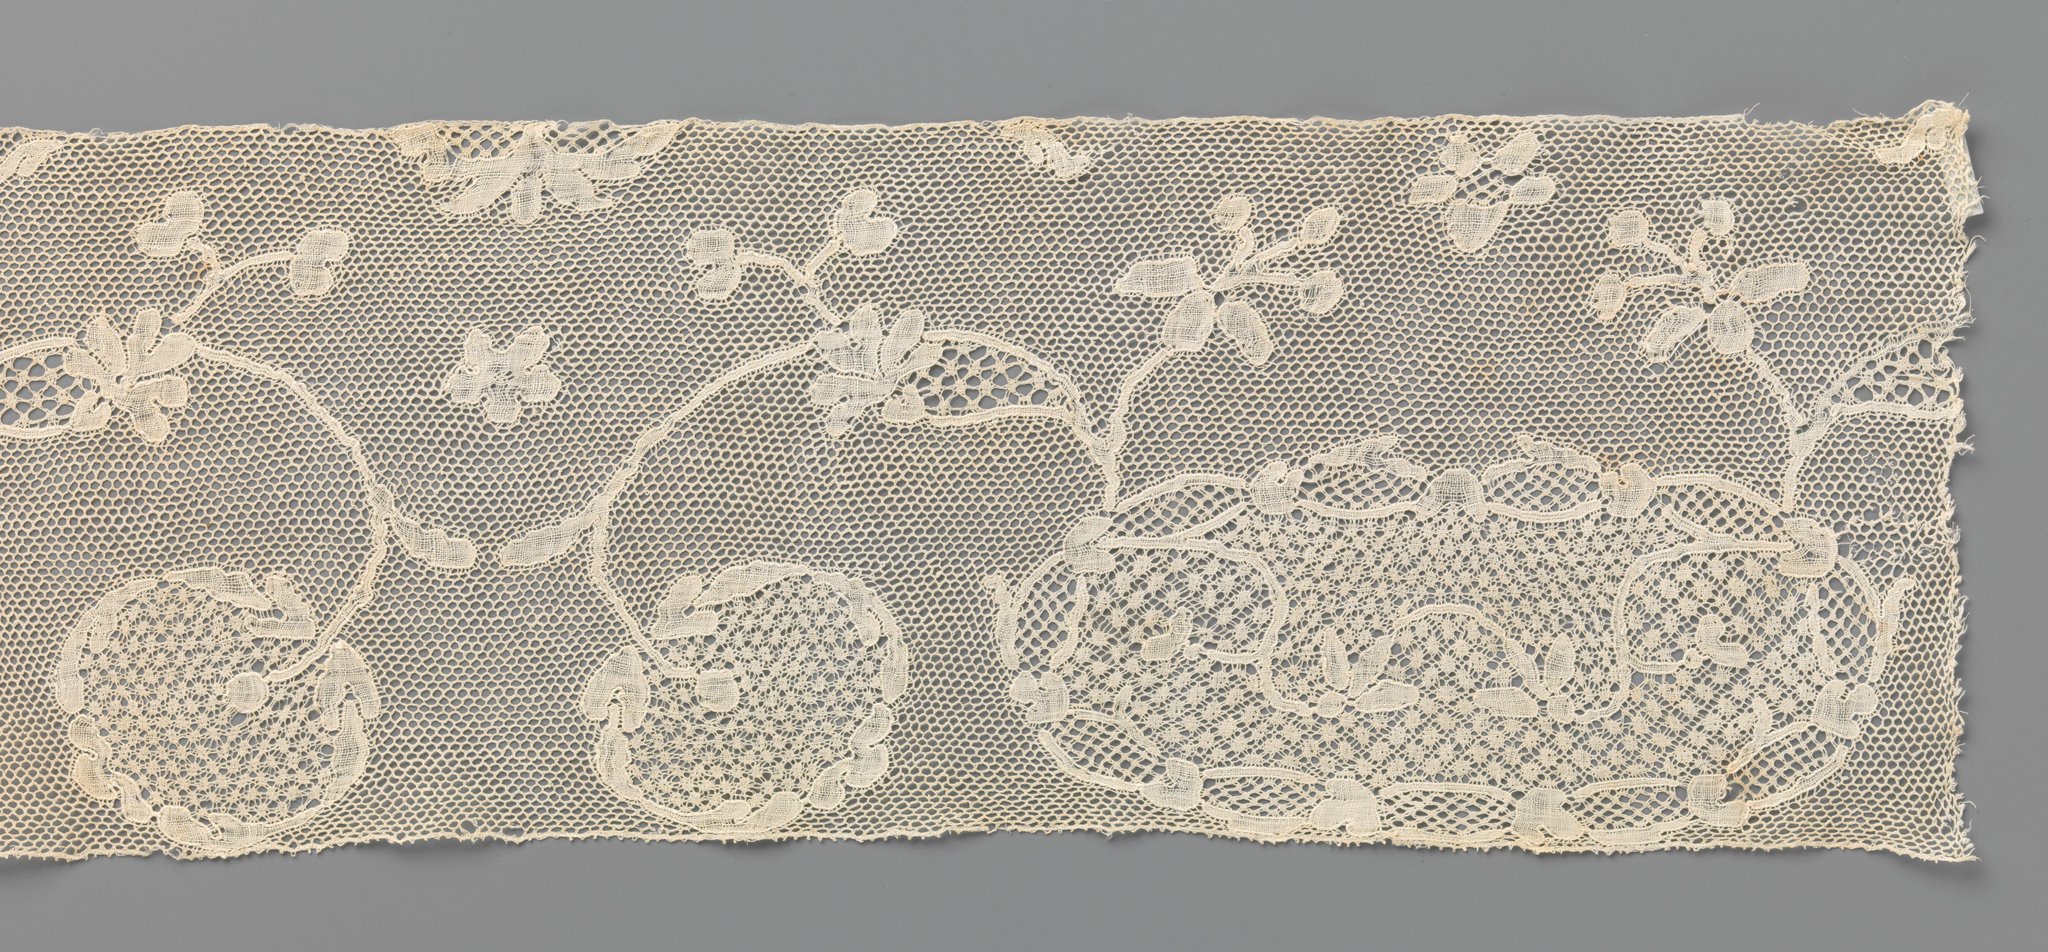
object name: strip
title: Strook kloskant met ovaalvormig cartouche en twee ronde bloemen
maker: Anonymous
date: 1700-1799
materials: linen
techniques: lace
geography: antwerp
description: Strook naturelkleurige kloskant, Antwerpse kant. Het zich herhalende en symmetrische patroon bestaat uit een ovaalvormig cartouche langs de onderrand, waarvan de bovenkant tot aan de middenlijn van de strook reikt. Vanuit de bovenkant ontspringt aan beide zijden van de cartouche een ronde bloem aan een lange omkrullende steel. De motieven zijn met elkaar verbonden door een maasgrond, een vierkante Valenciennes-grond. De motieven zijn gemaakt in linnenslag met dikkere en glimmende contourdraden. In onder andere de bloemen en het cartouche zijn als siergrond verschillende sneeuwvlokkengronden toegepast. Boven- en onderzijde zijn recht afgewerkt, waarbij de onderzijde is voorzien van picots.